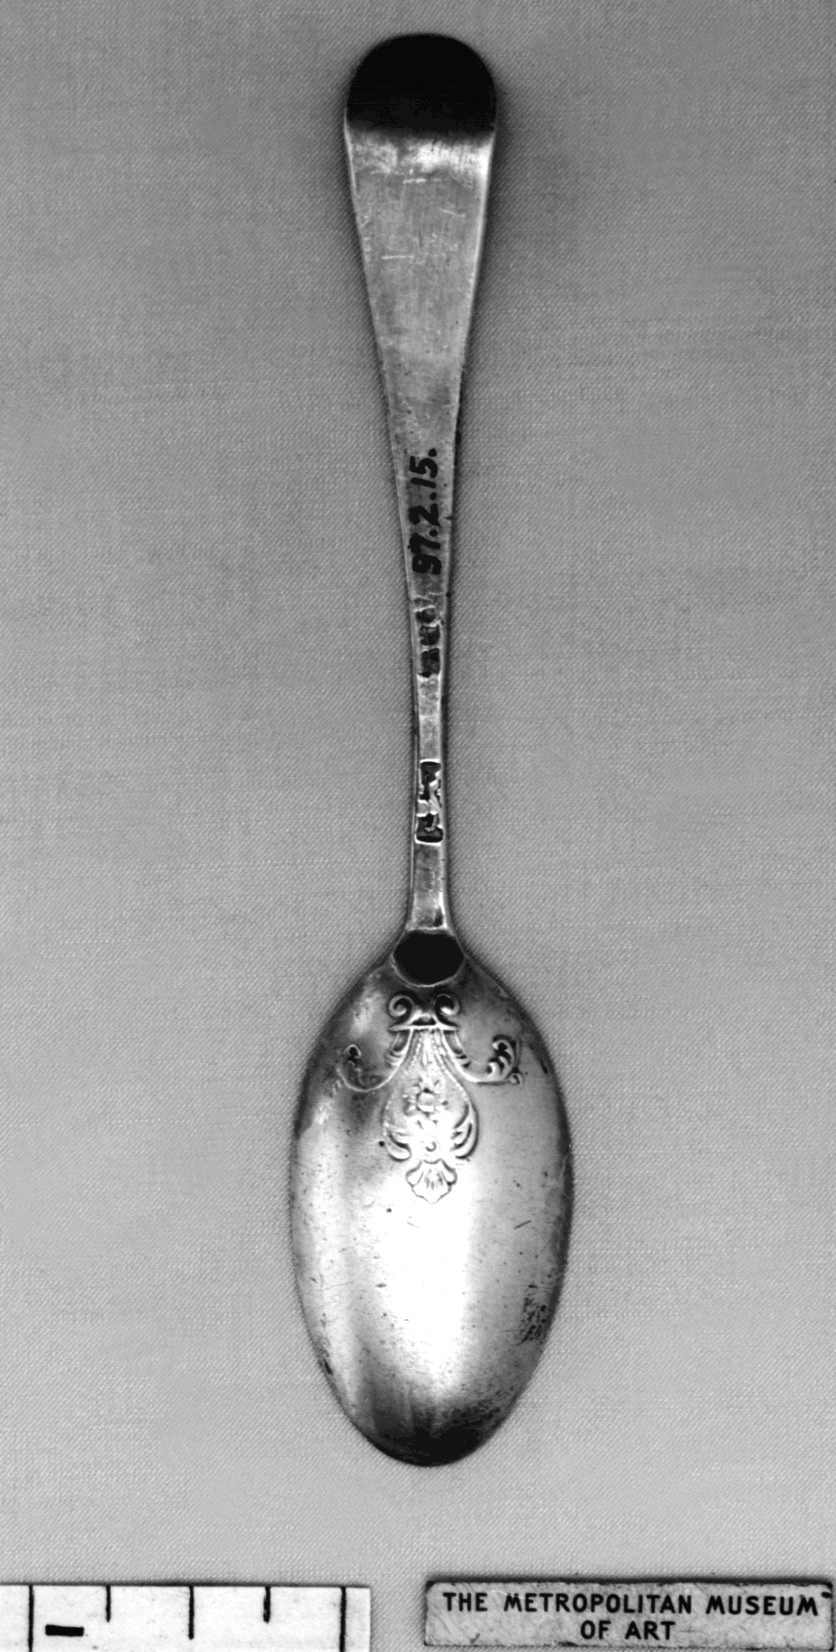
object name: coffee spoon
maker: benjamin brewood ii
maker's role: maker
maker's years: 1755-1855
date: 1701-1800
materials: silver